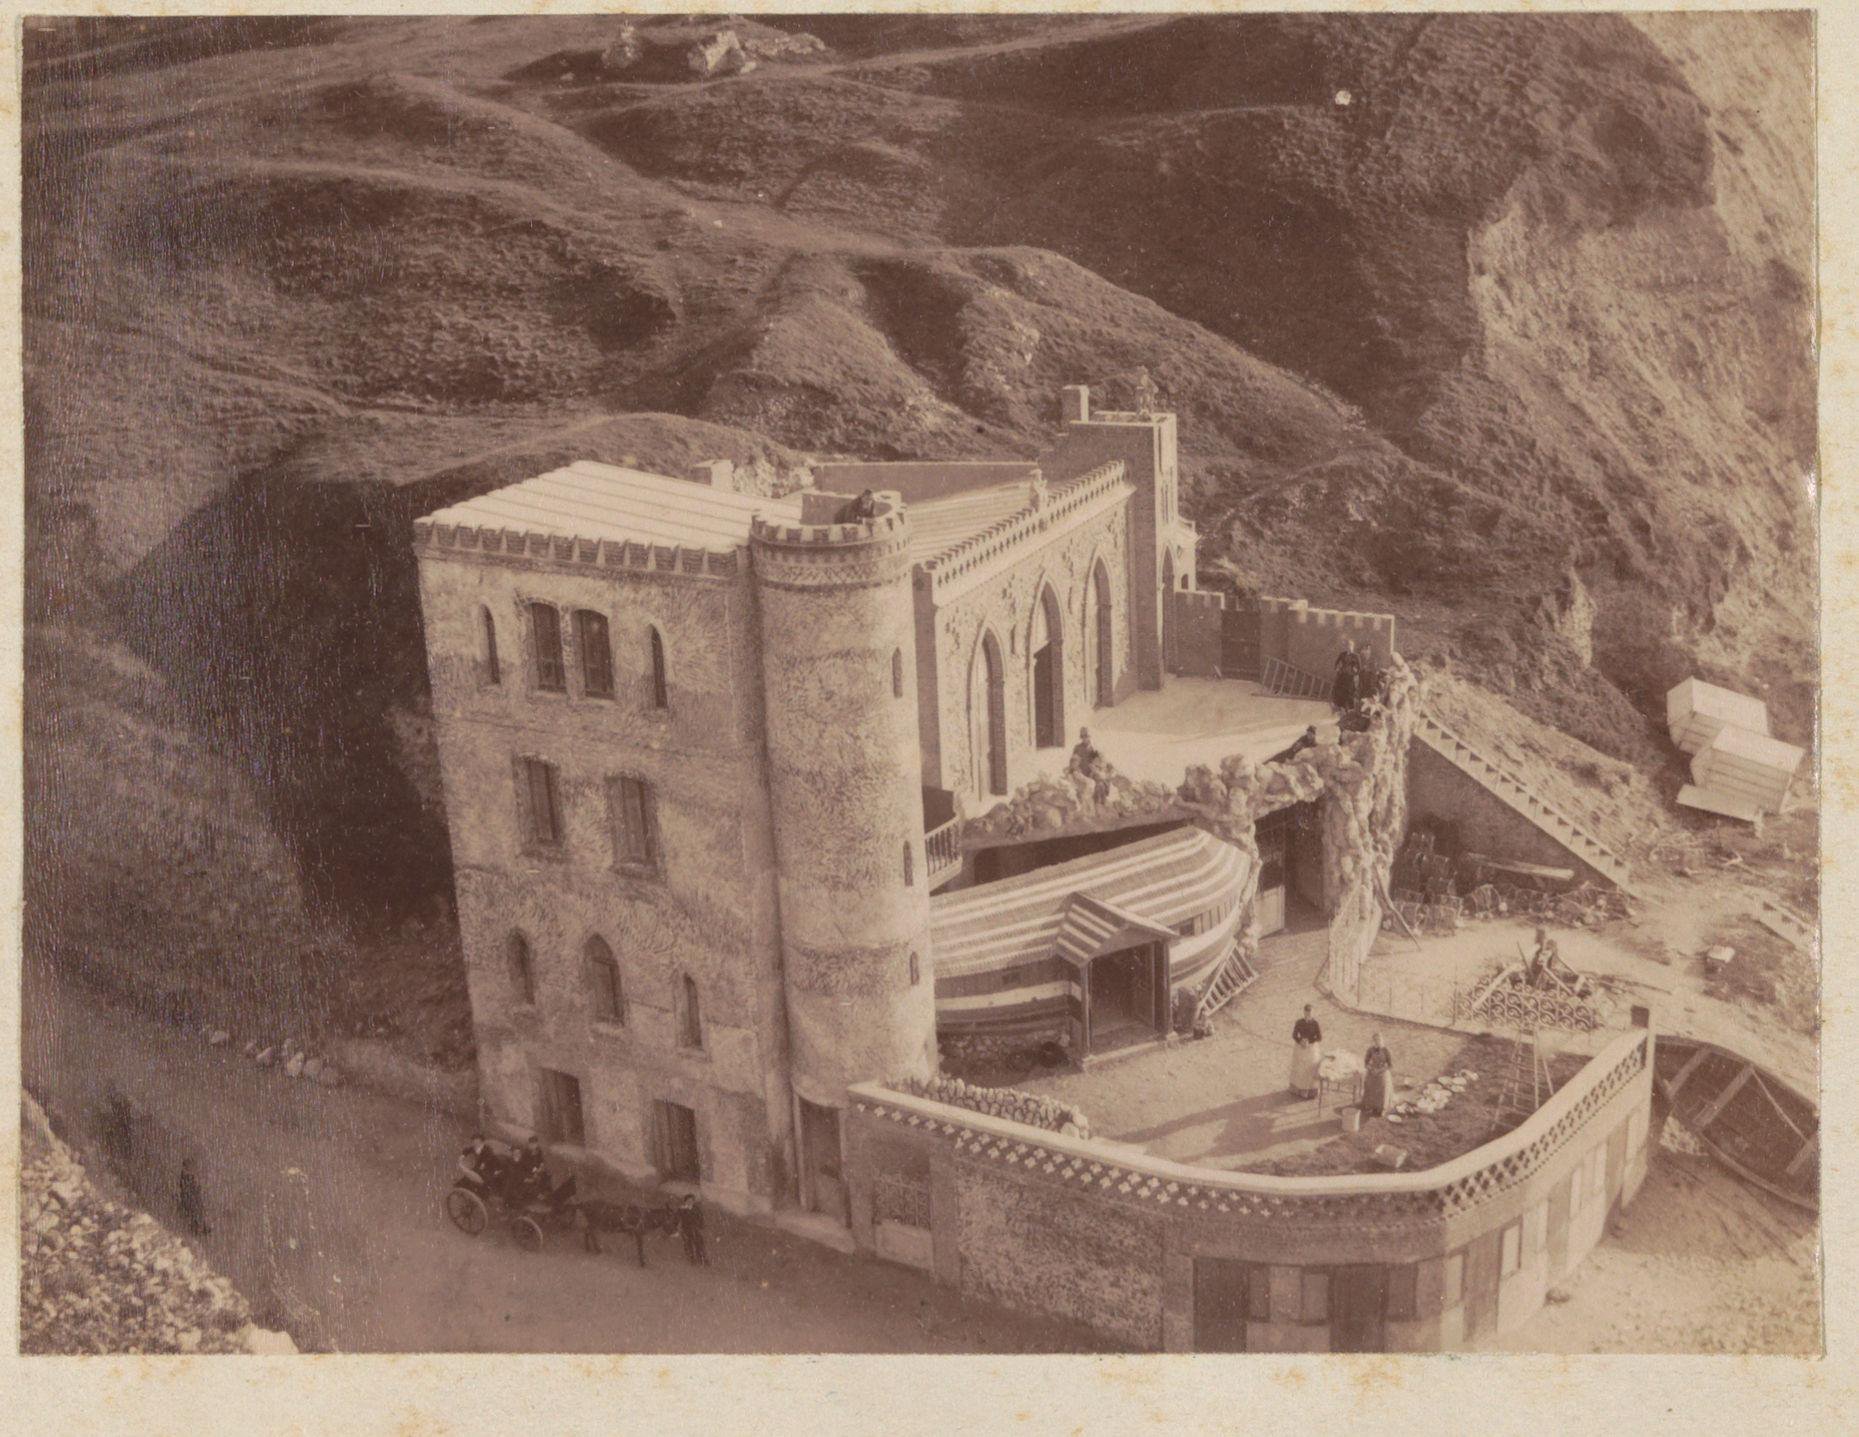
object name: photograph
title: Exterieur van een villa in Saint-Jouin-Bruneval, van bovenaf gezien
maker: Anonymous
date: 1809-1885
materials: photographic support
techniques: albumen print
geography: saint-jouin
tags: castle, villa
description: Onderdeel van Album van een Franse amateurfotograaf met opnames van familie, militairen, industrie, landschappen en bezienswaardigheden in Frankrijk.